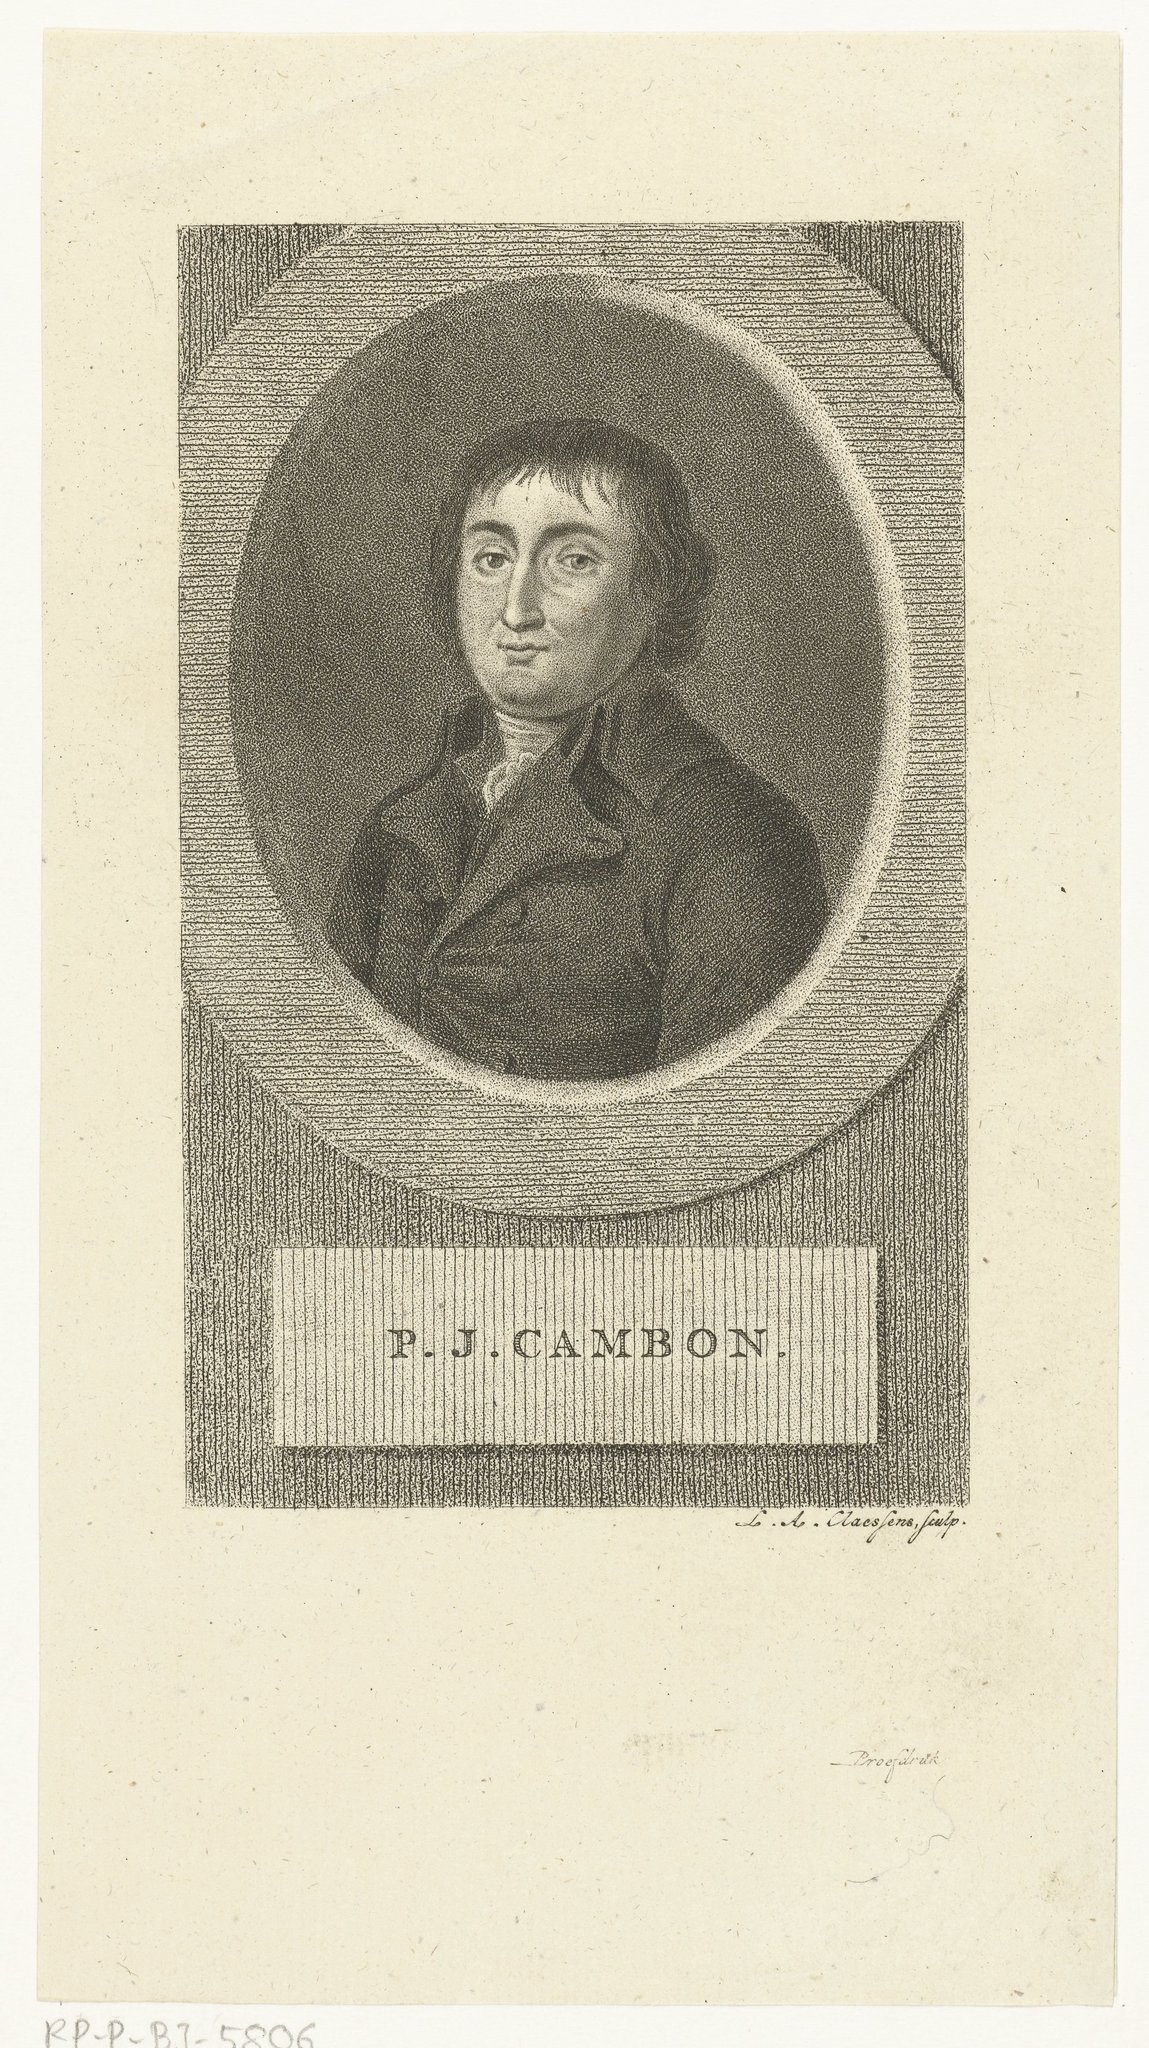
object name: print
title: Portret van Pierre Joseph Cambon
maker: lambertus antonius claessens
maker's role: draughtsman, print maker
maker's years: 1763-1834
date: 1792-1808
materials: paper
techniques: engraving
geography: amsterdam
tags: brussels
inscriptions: collector's mark: Lugt 2228